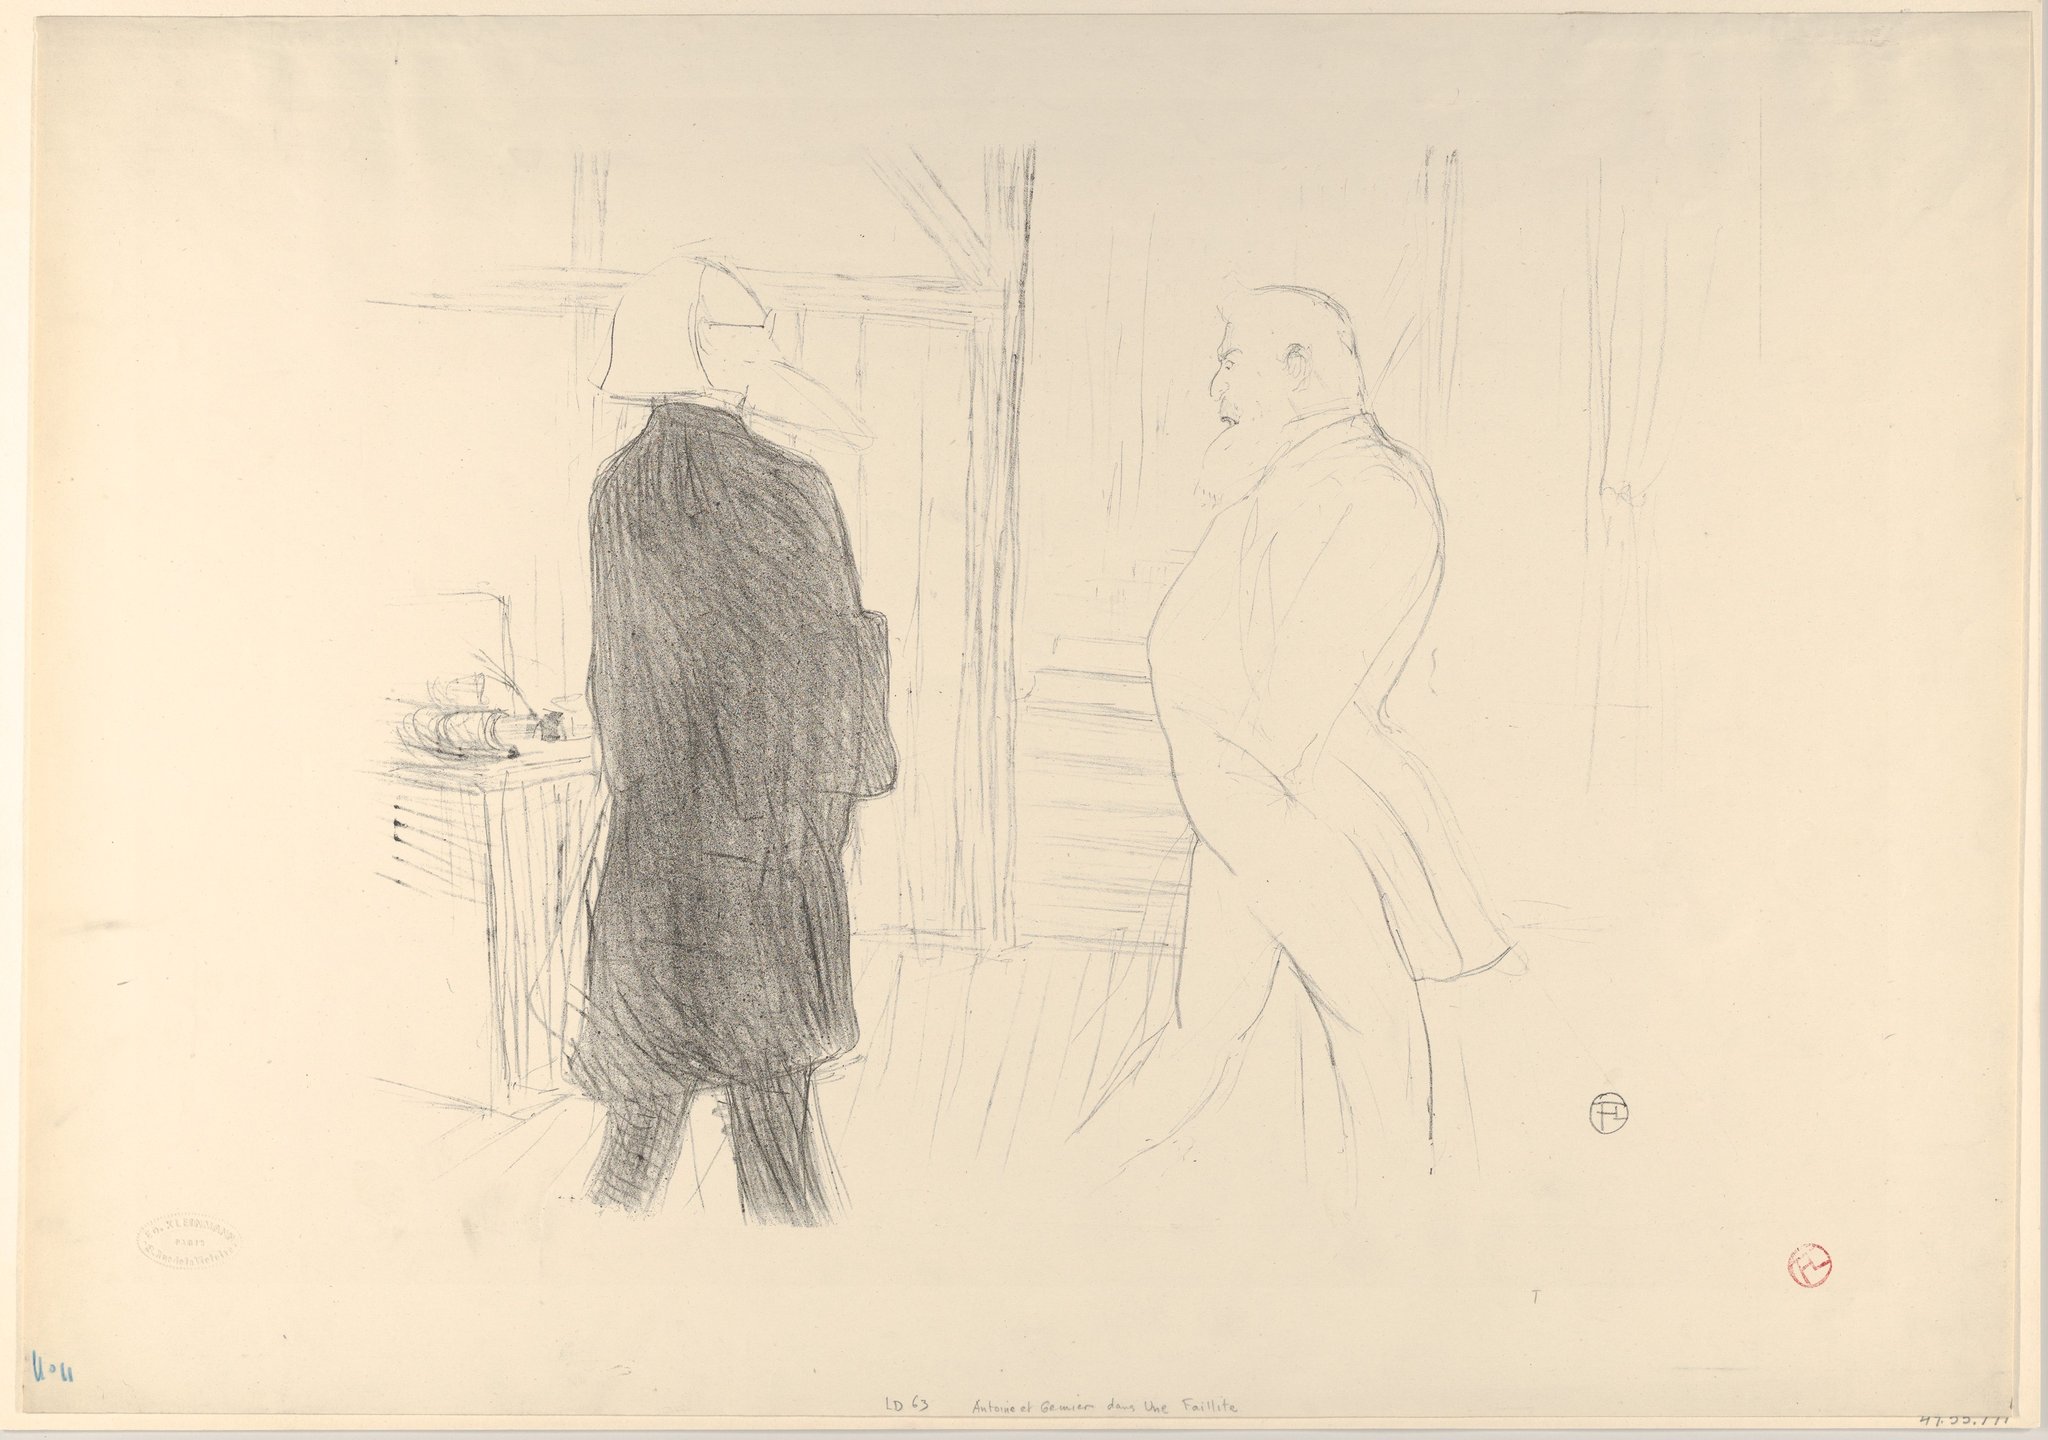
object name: print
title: André Antoine and Fermin Gémier in "A Bankruptcy"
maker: henri de toulouse-lautrec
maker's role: artist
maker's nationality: french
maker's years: 1864-1901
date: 1893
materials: crayon, ink, paper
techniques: lithograph, printing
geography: france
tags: men,walking